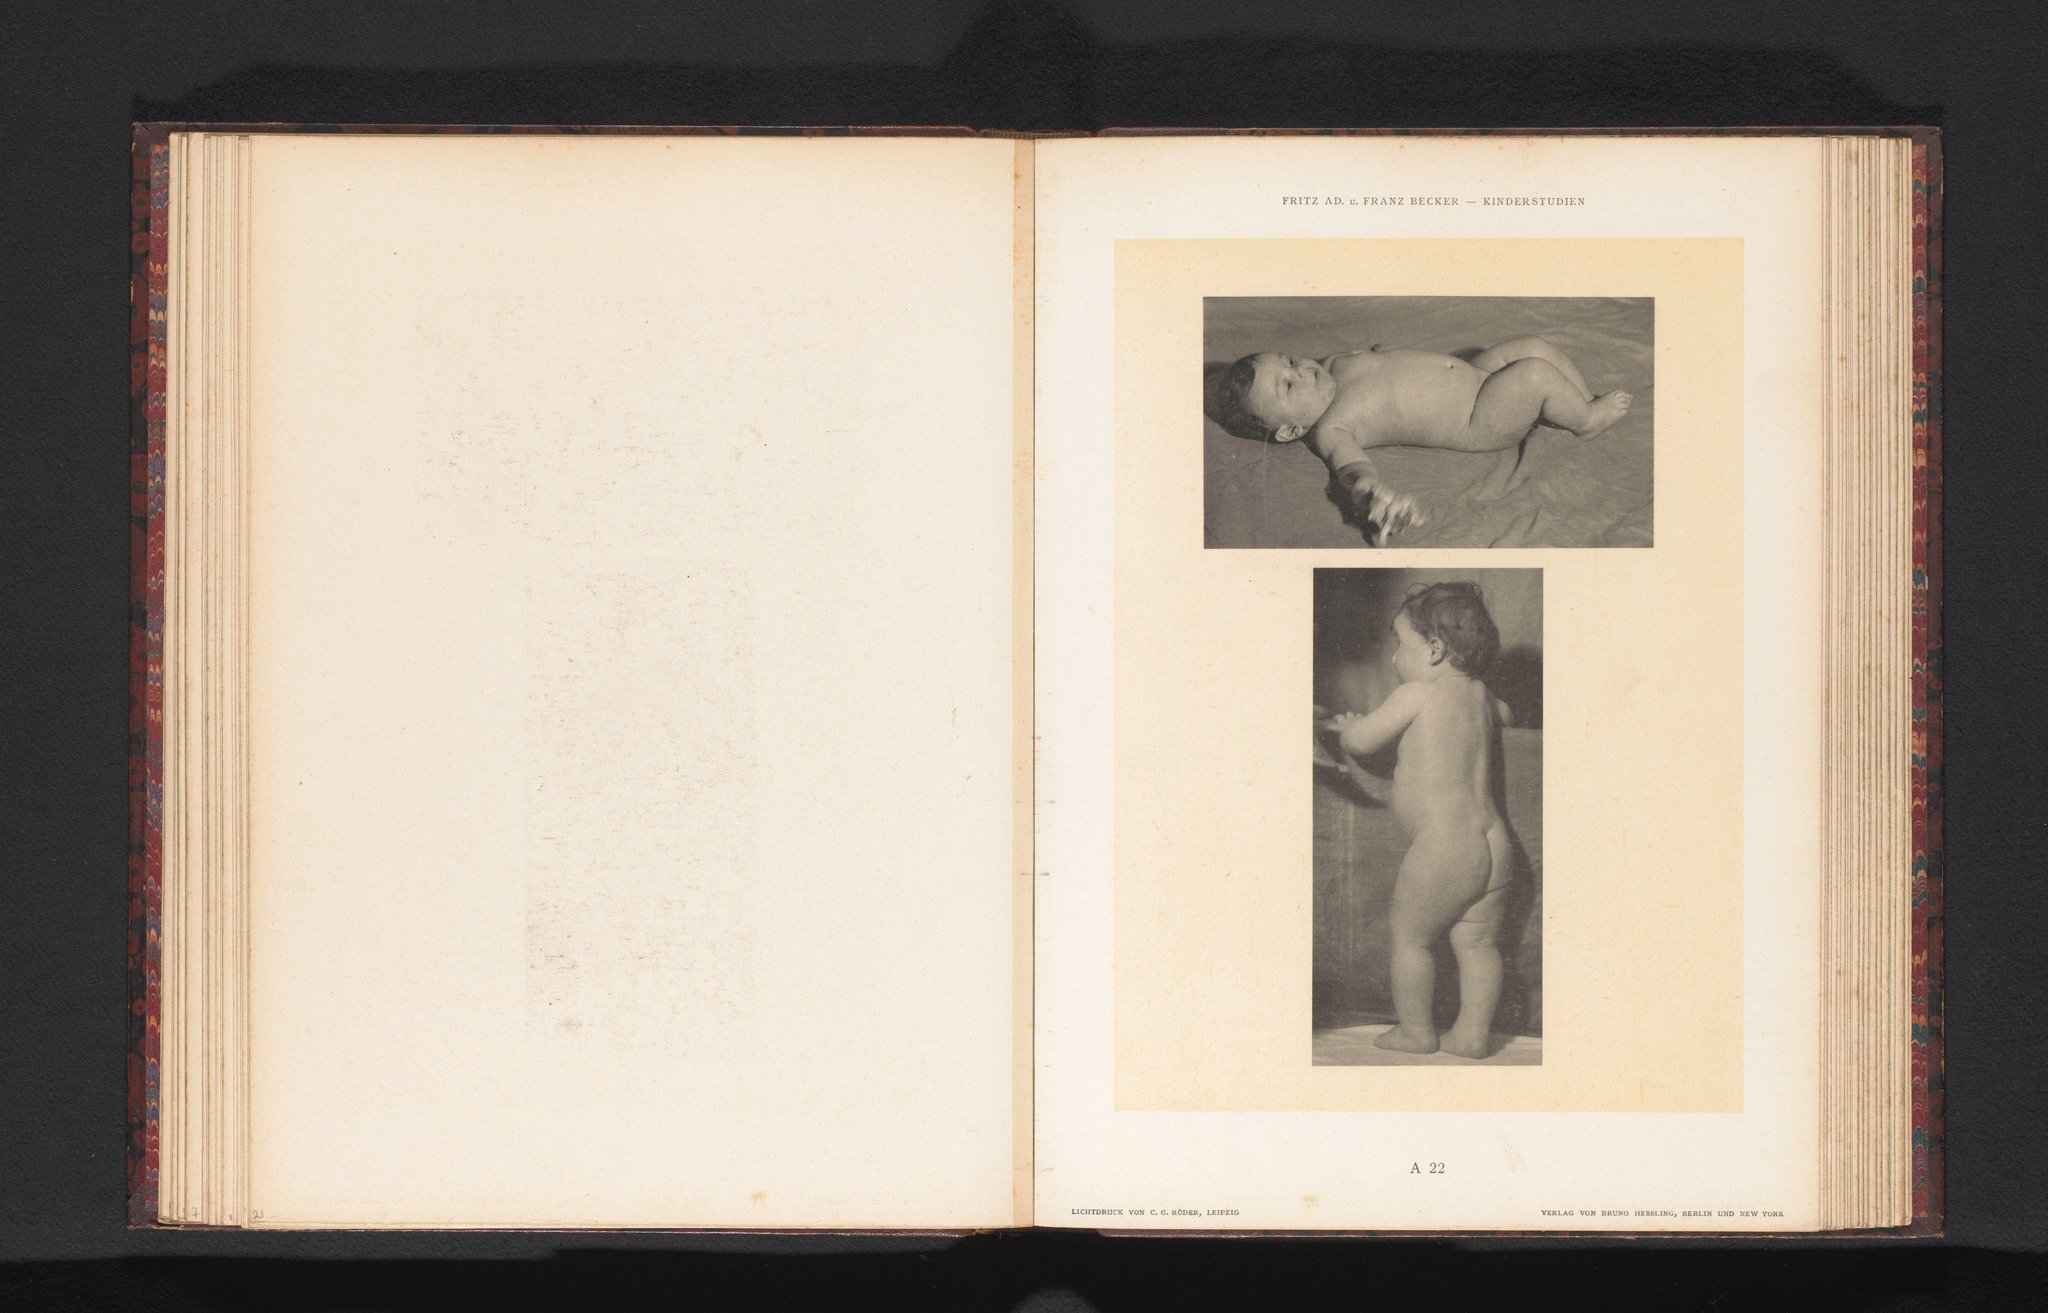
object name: photomechanical print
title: Twee afbeeldingen van een naakte jongen, liggend en staand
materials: paper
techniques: photograph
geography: new york city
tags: toddler (male), lying figure, standing figure (+ back view)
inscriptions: number: ‘A 22’